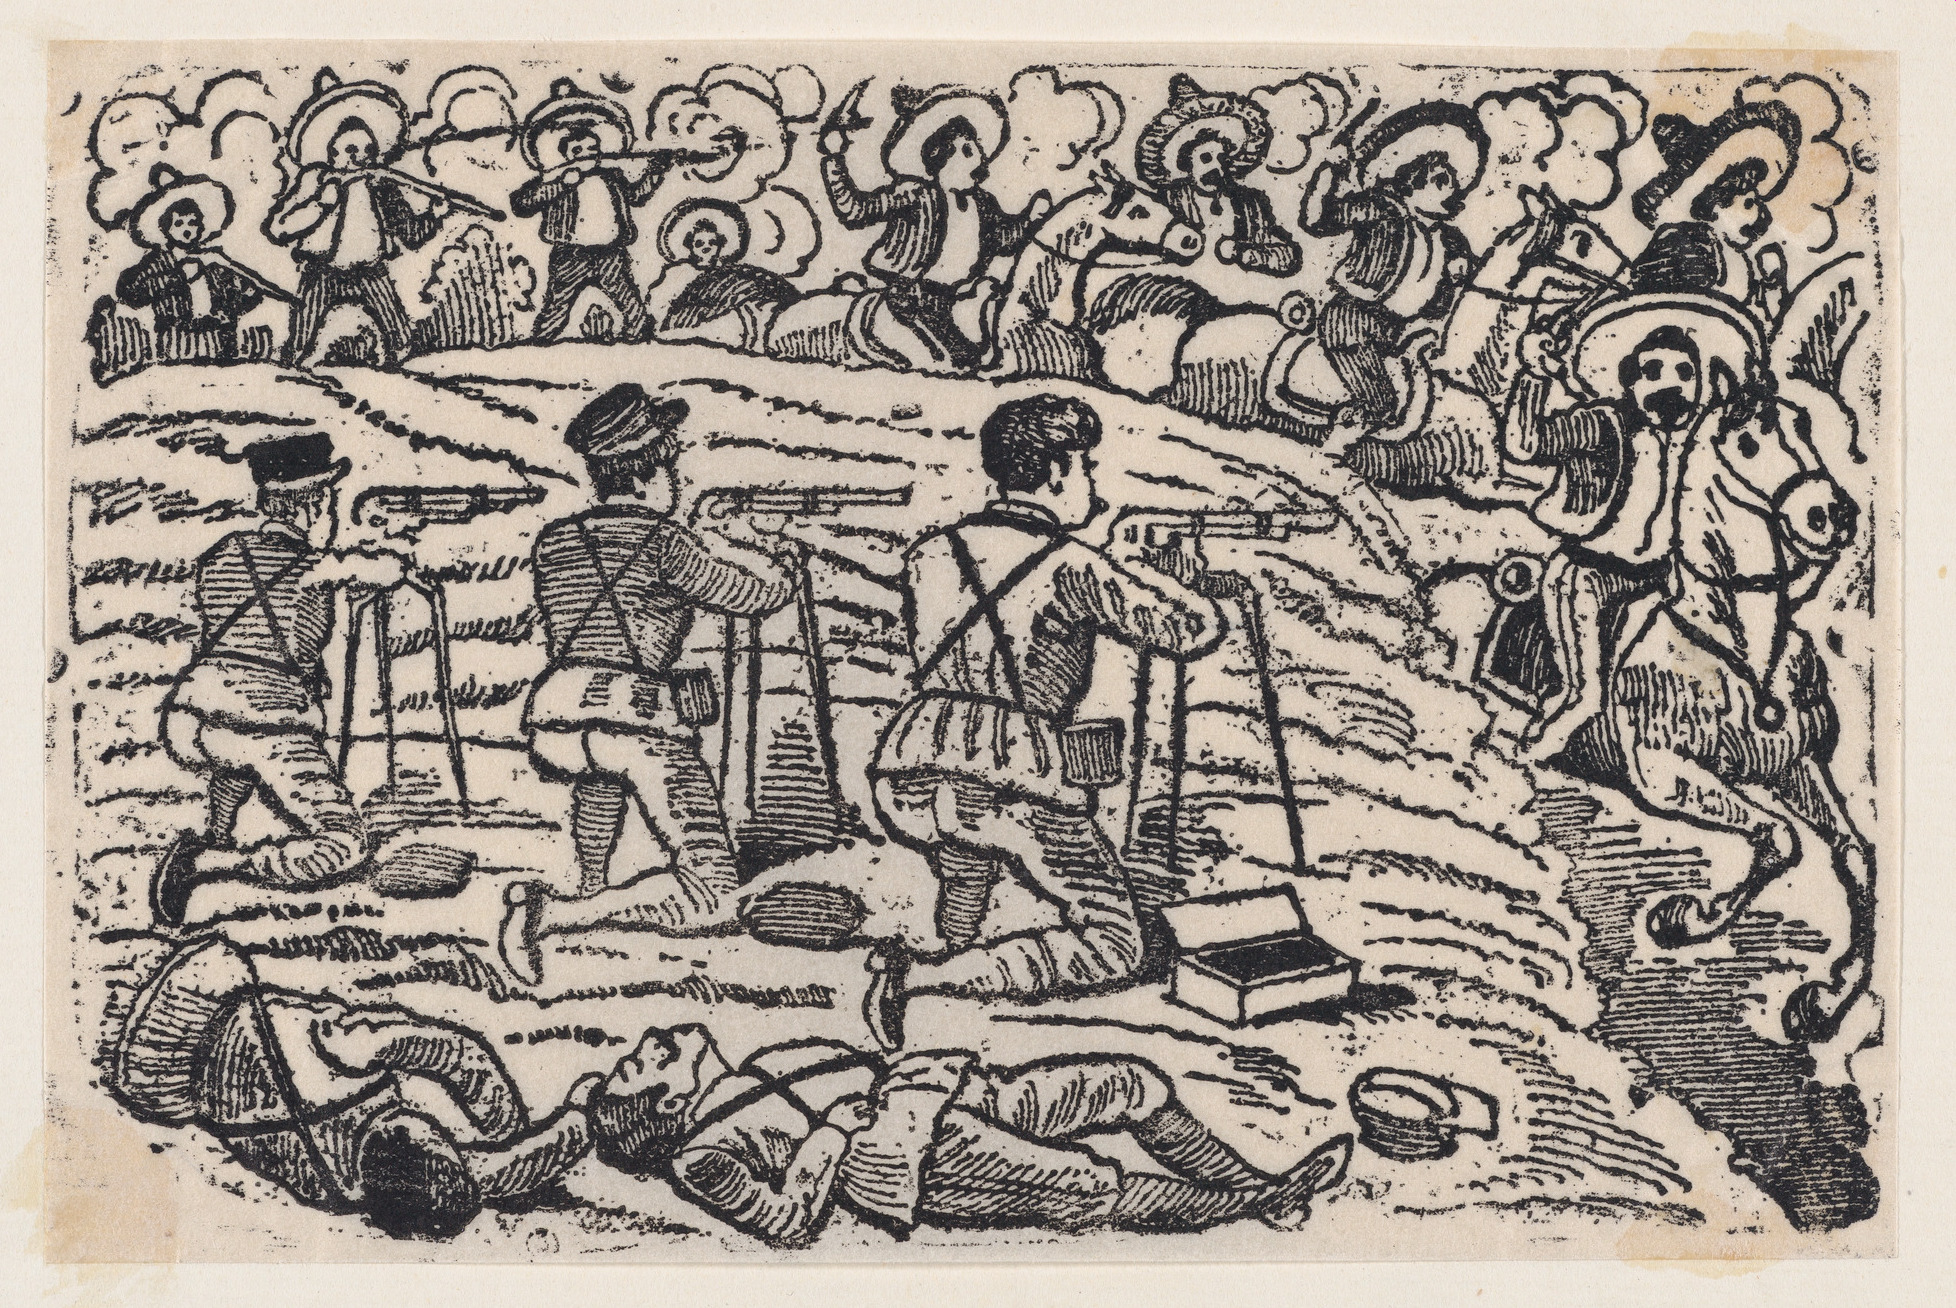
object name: print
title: A battle between Federal forces and Zapata followers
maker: josé guadalupe posada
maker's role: artist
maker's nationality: mexican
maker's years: 1852-1913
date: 1910-1912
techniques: lithography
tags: battles,soldiers,firearms,men,horses